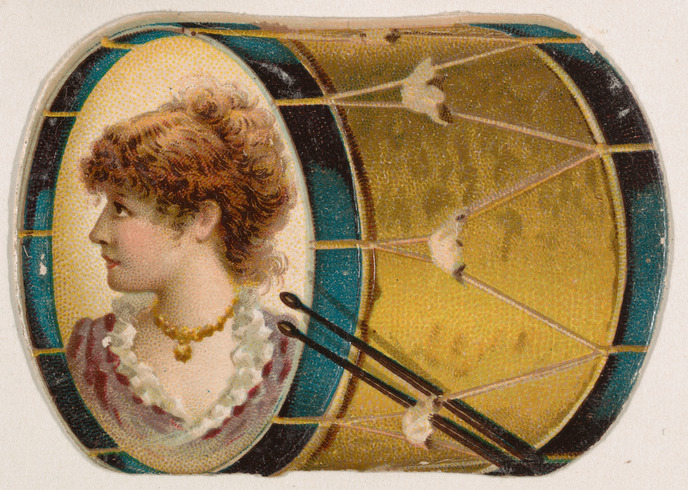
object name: print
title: Drum, from the Novelties series (N228, Type 4) issued by Kinney Bros.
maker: kinney brothers tobacco company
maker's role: publisher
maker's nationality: american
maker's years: 1869-2011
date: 1889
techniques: color lithograph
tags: profiles,women,drums